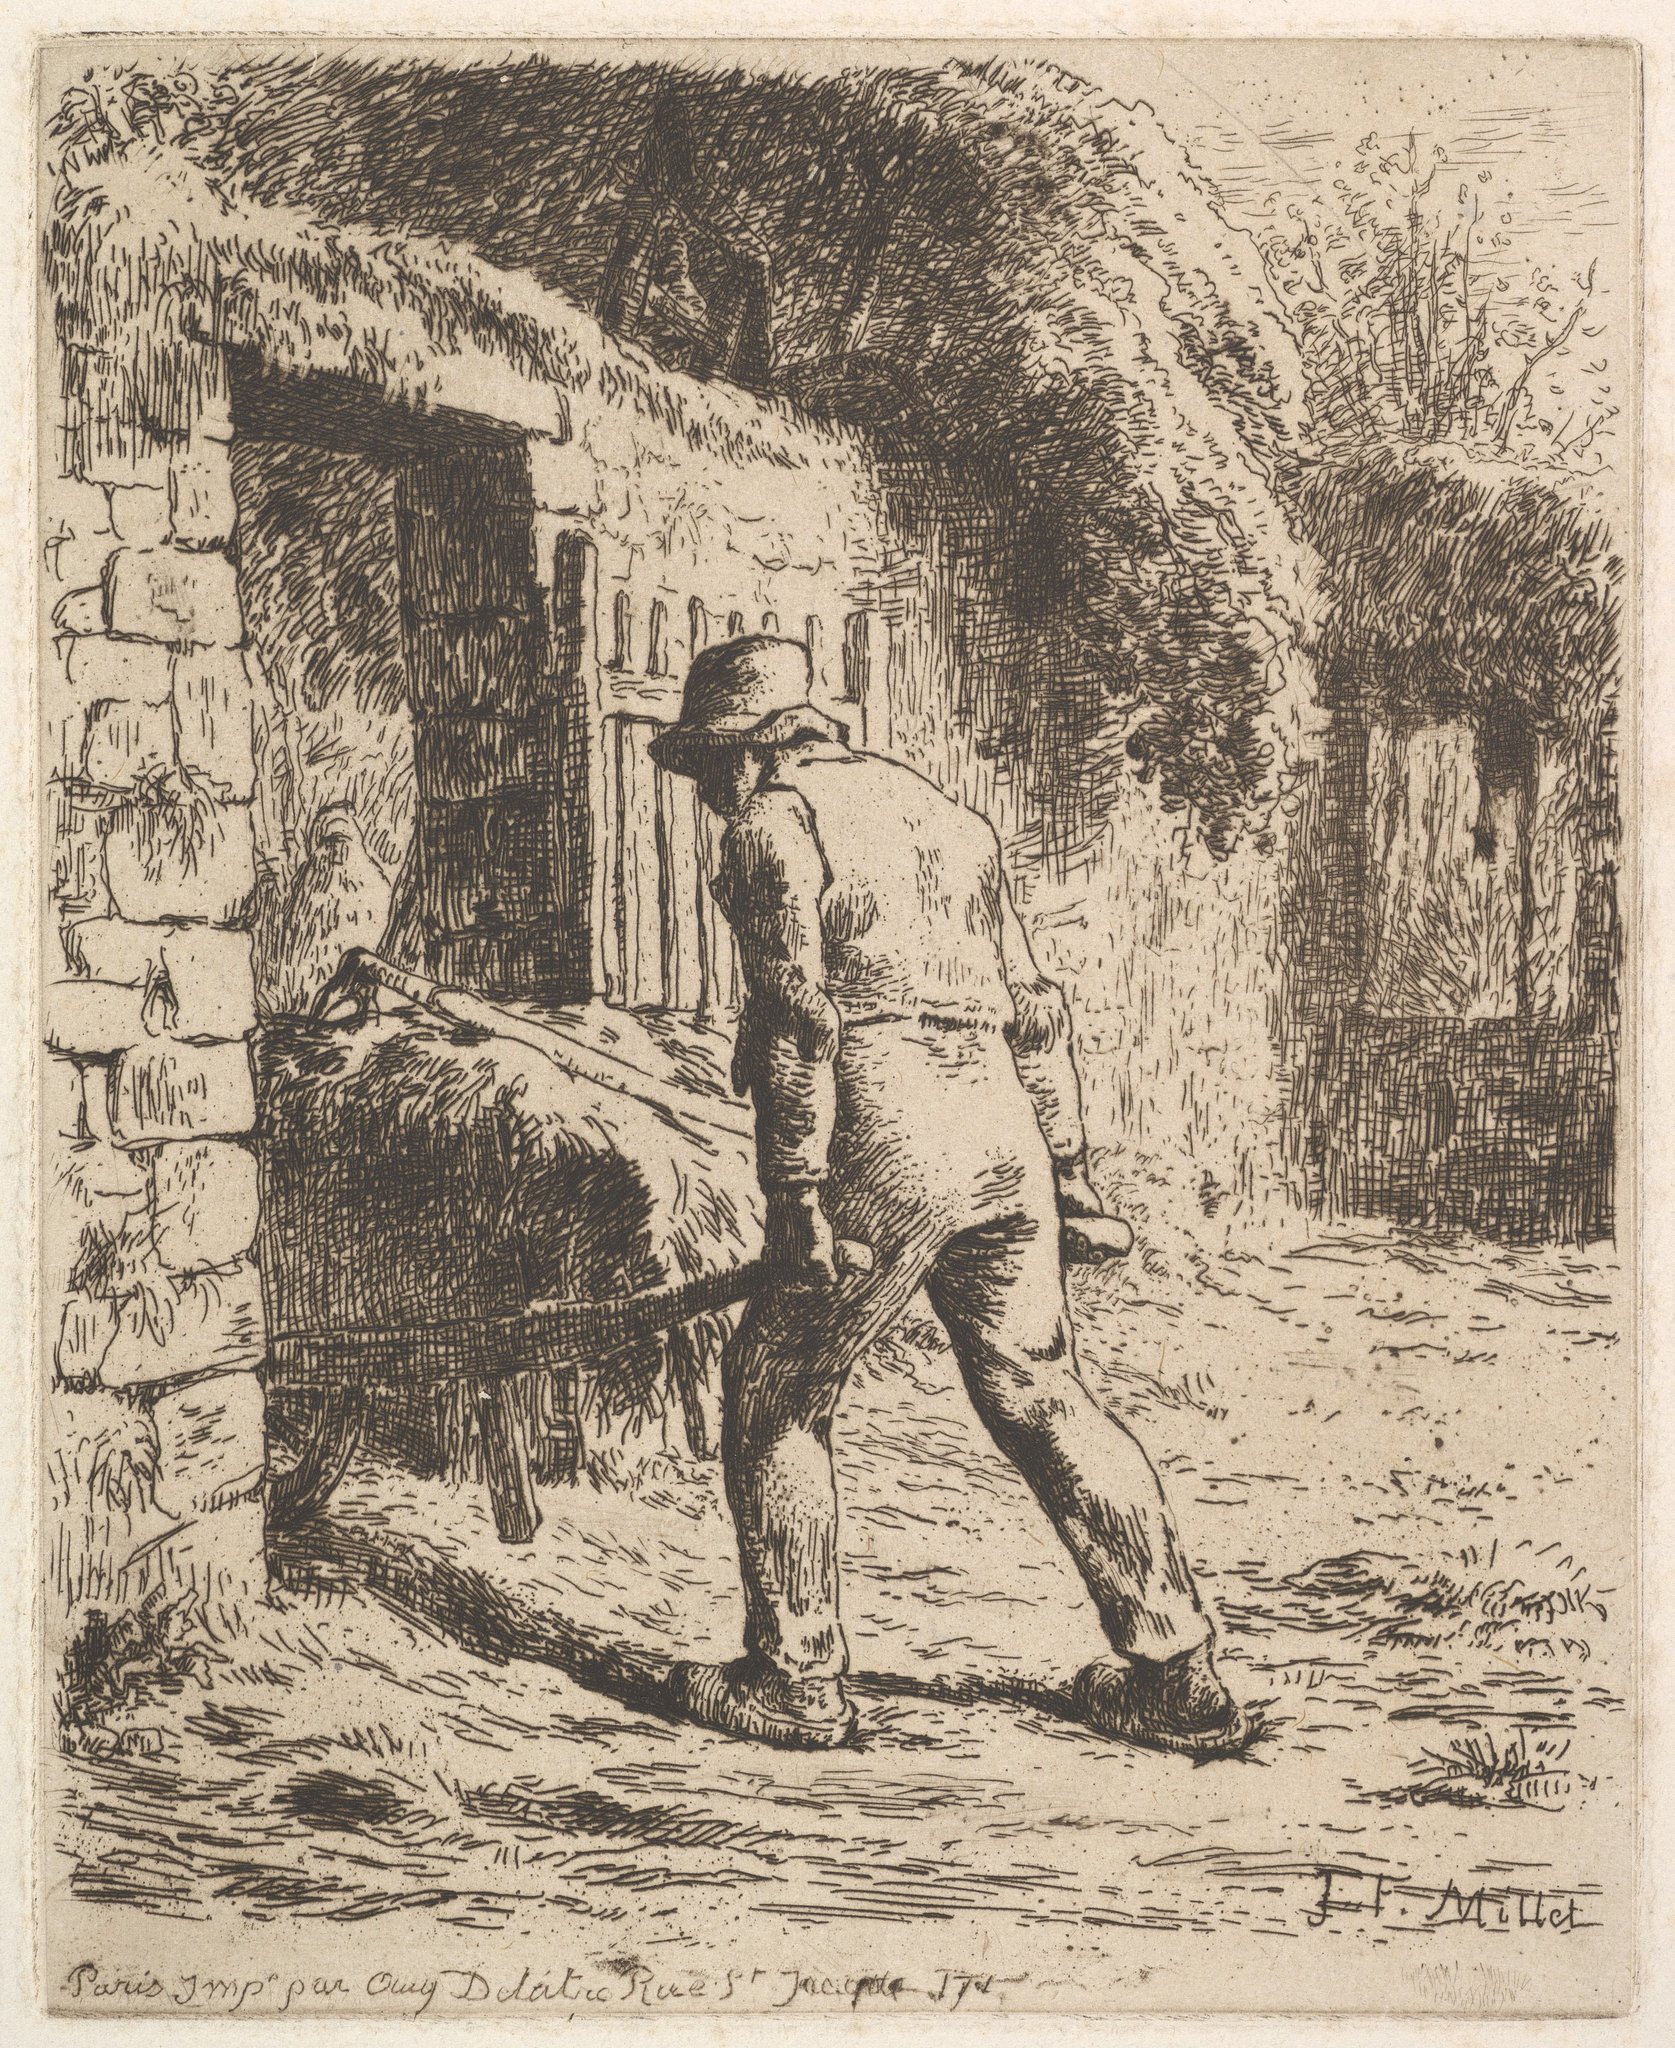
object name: print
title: Peasant Pushing a Wheelbarrow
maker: jean-françois millet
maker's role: artist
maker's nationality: french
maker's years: 1814-1875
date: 1855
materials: ink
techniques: etching, printing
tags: houses,men,working